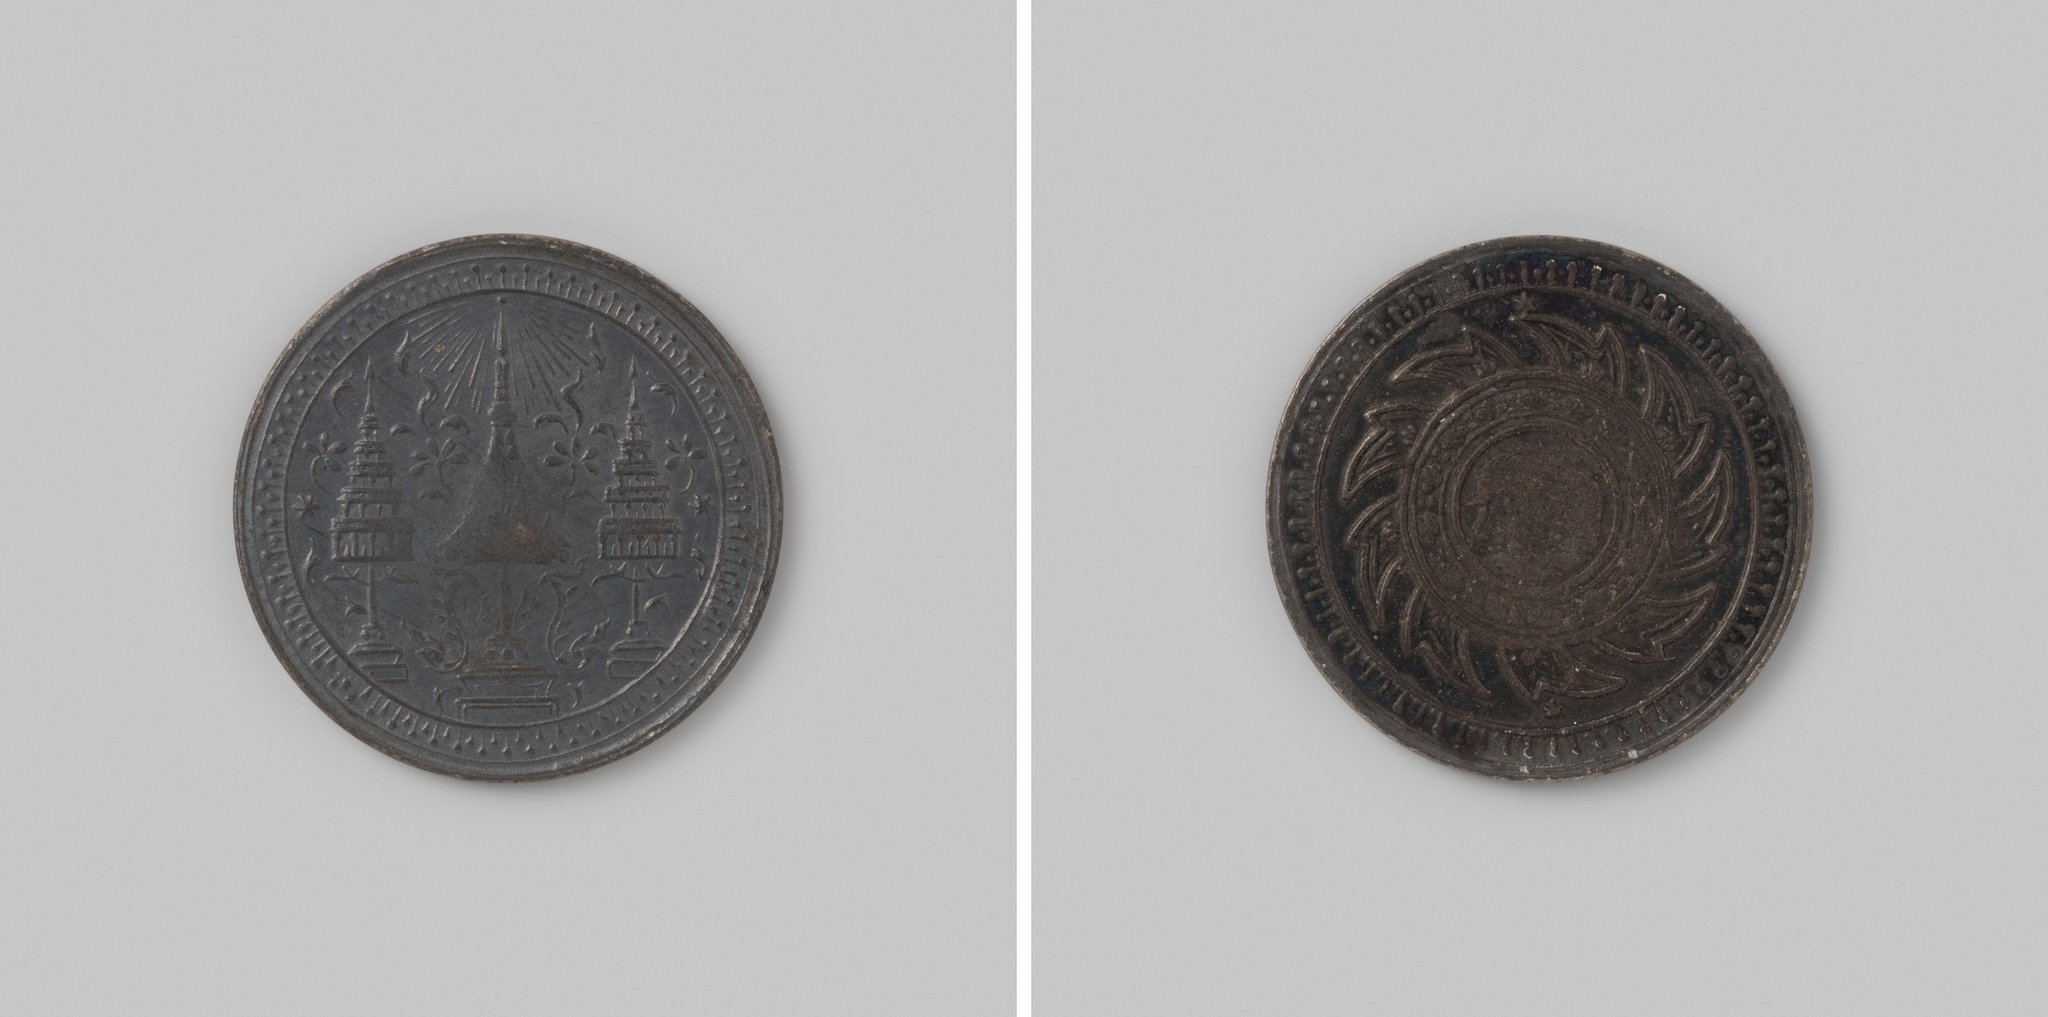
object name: coin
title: Thailand, salung of 2 fuang, Maha Mongkut,1851-1868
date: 1860-1868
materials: silver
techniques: striking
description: Zilveren munt. Voorzijde: tussen twee uitvouwbare schermen koninklijke kroon van Thailand. Keerzijde: chakra met in het midden een olifant. Boven en onder de chakra in totaal twee stippen, waarde-aanduiding: 2 fuang. Gladde rand.